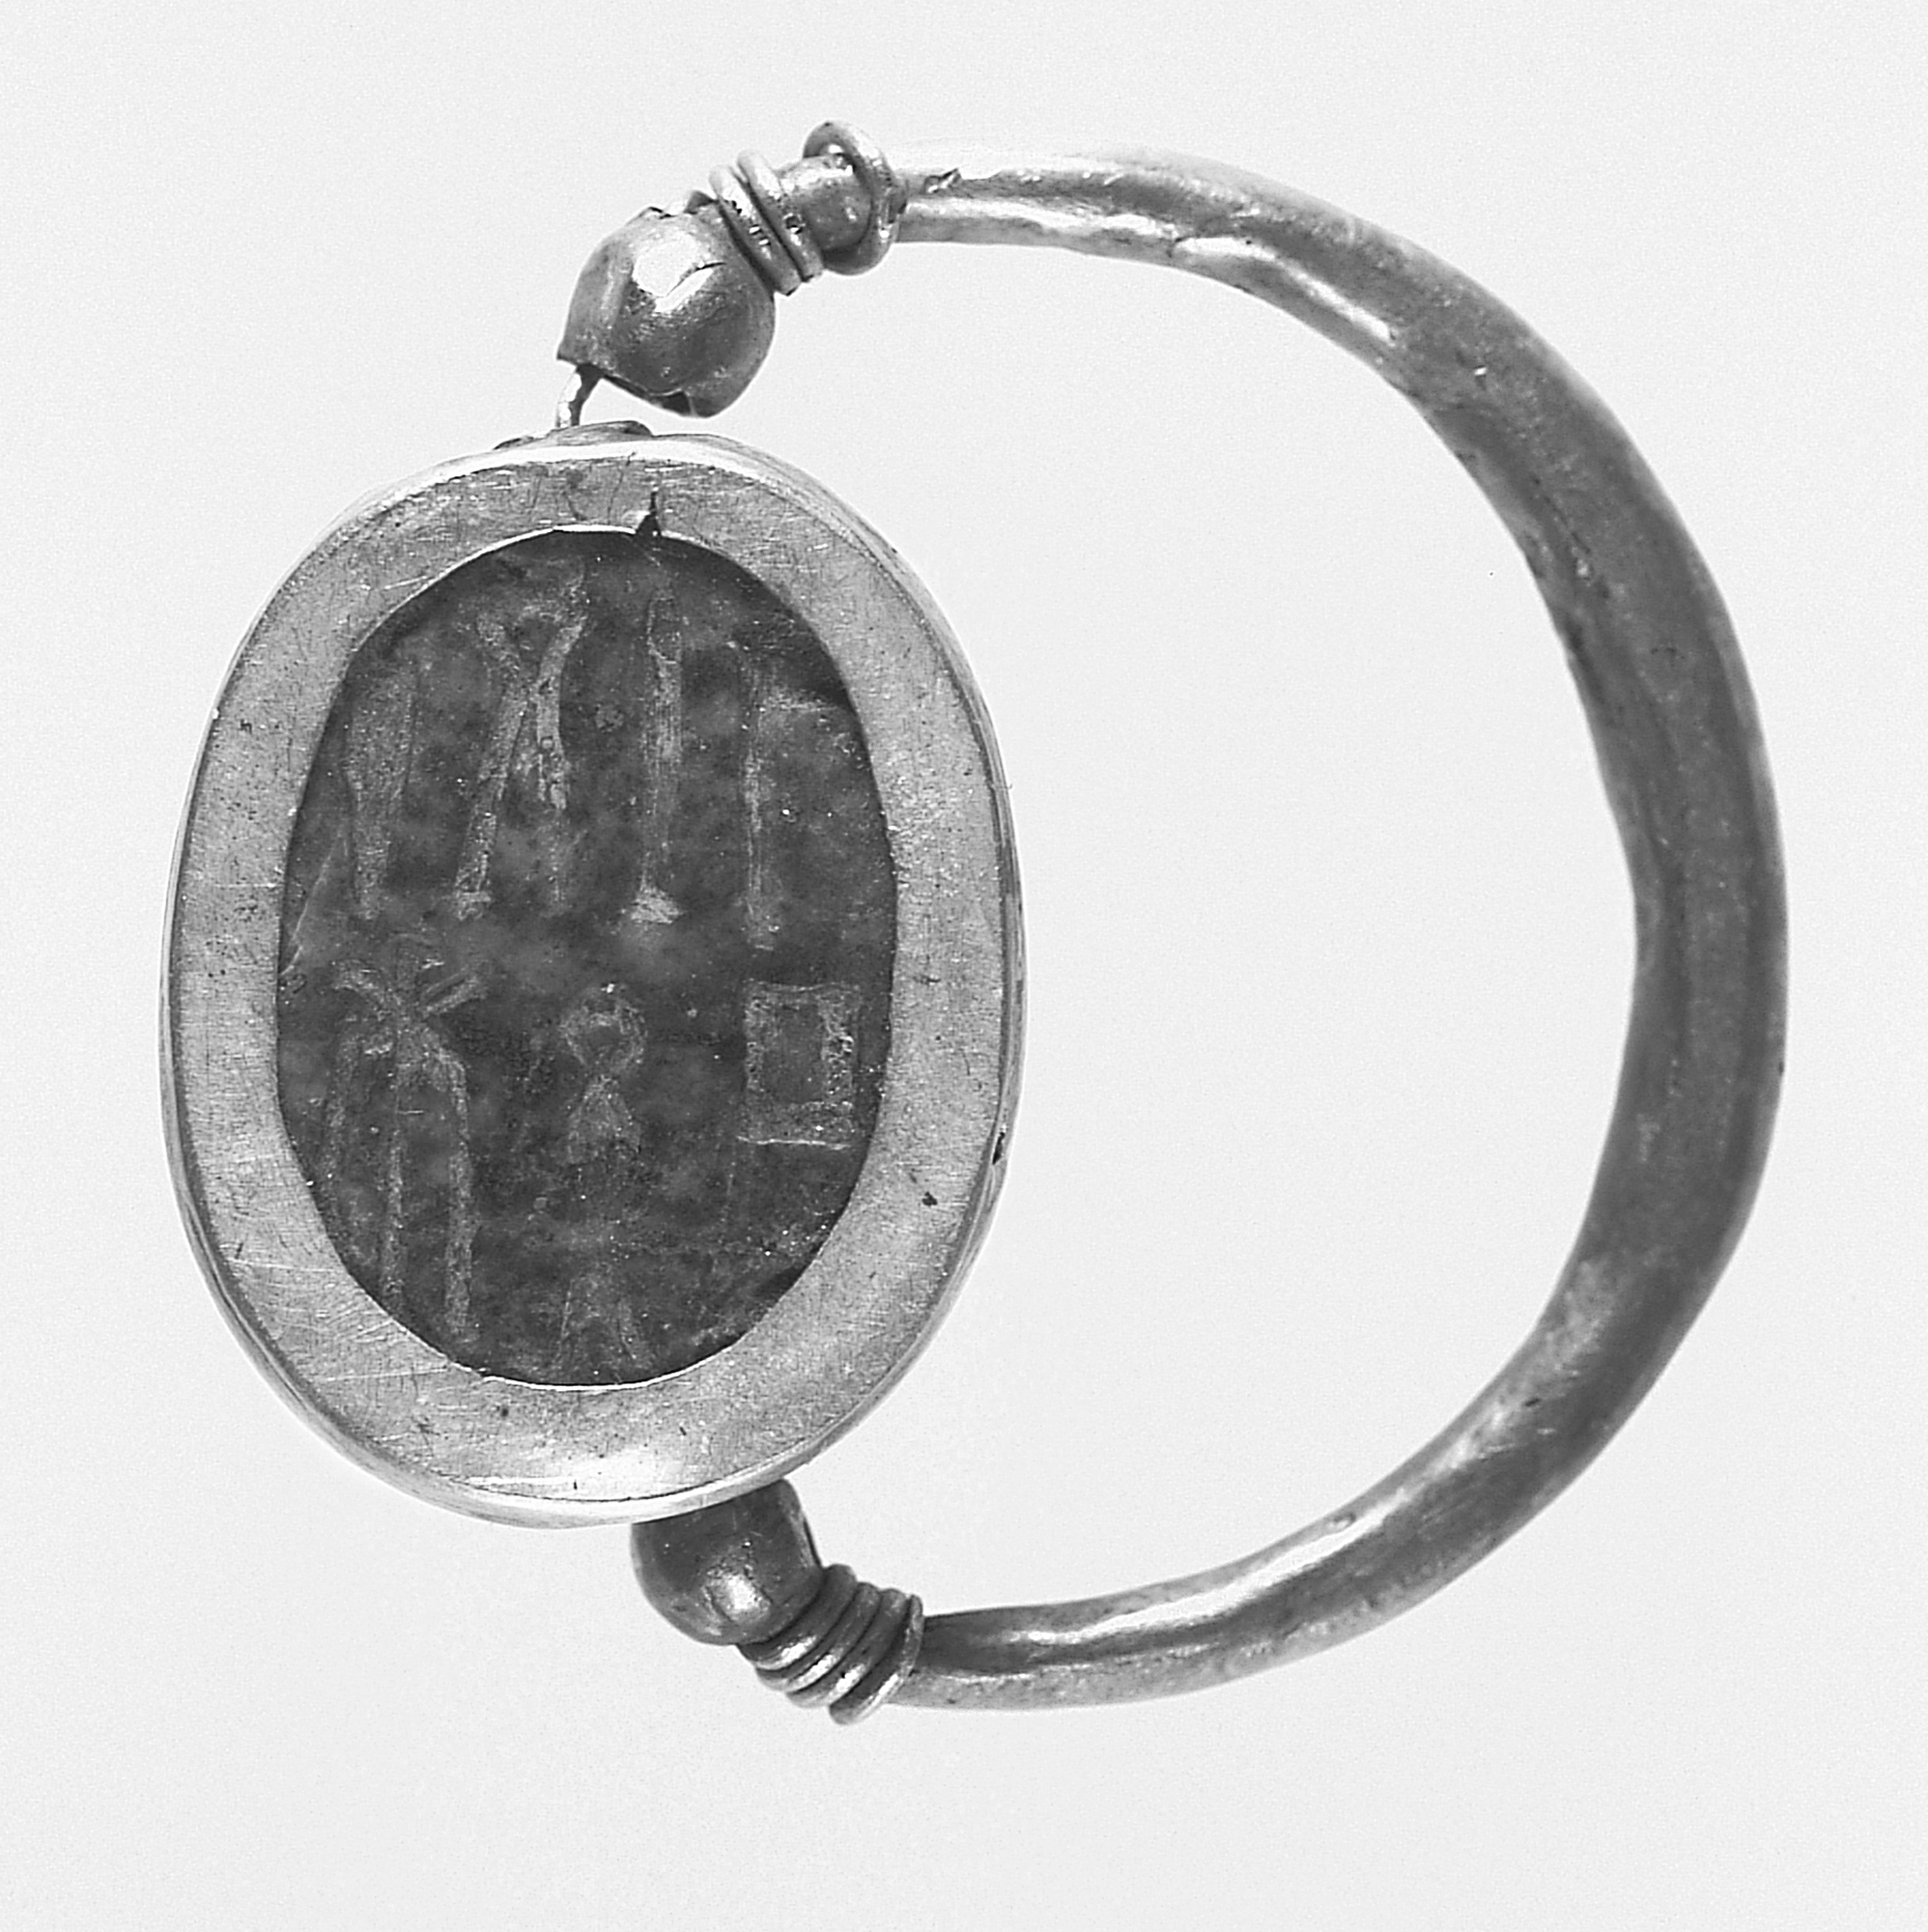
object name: ring with scarab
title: Ring, scarab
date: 1550-1295 BCE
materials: gold, lapis lazuli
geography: egypt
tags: scarabs